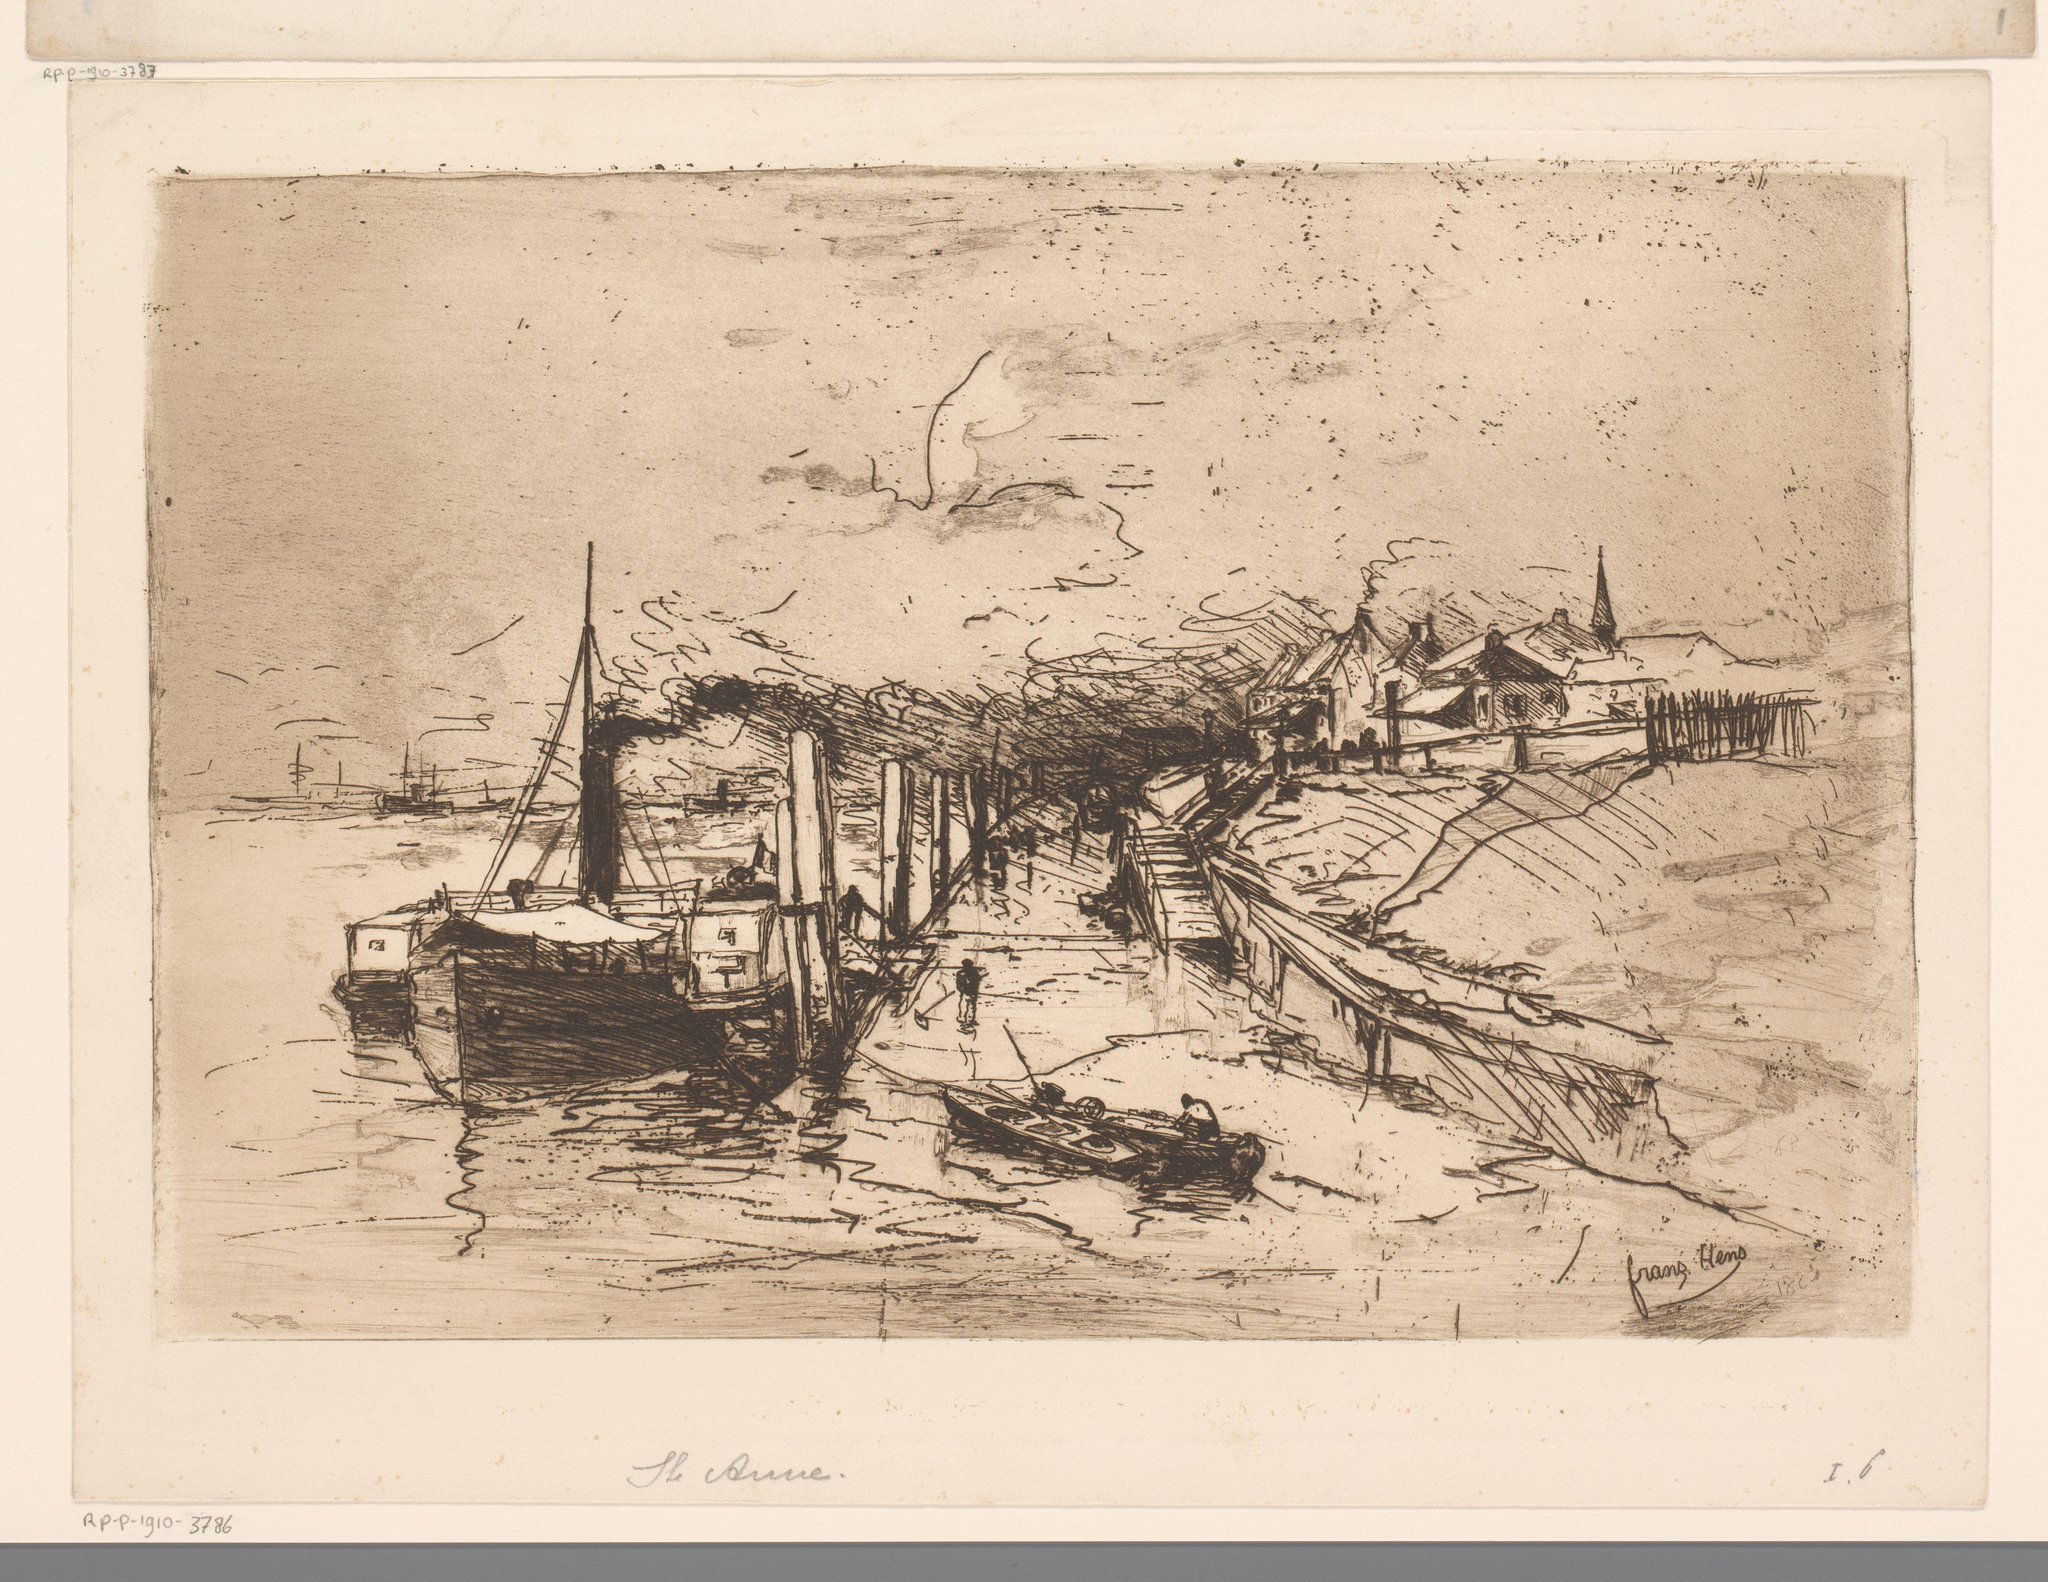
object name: print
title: Gezicht op de haven te Sint-Anne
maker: frans hens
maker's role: print maker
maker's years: 1856-1928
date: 1885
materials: paper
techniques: etching, intaglio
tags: harbour, landscapes with waters, waterscapes, seascapes (in the temperate zone), ship bound for the harbour, pier, quay, wharf, belgium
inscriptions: collector's mark: Lugt 2228